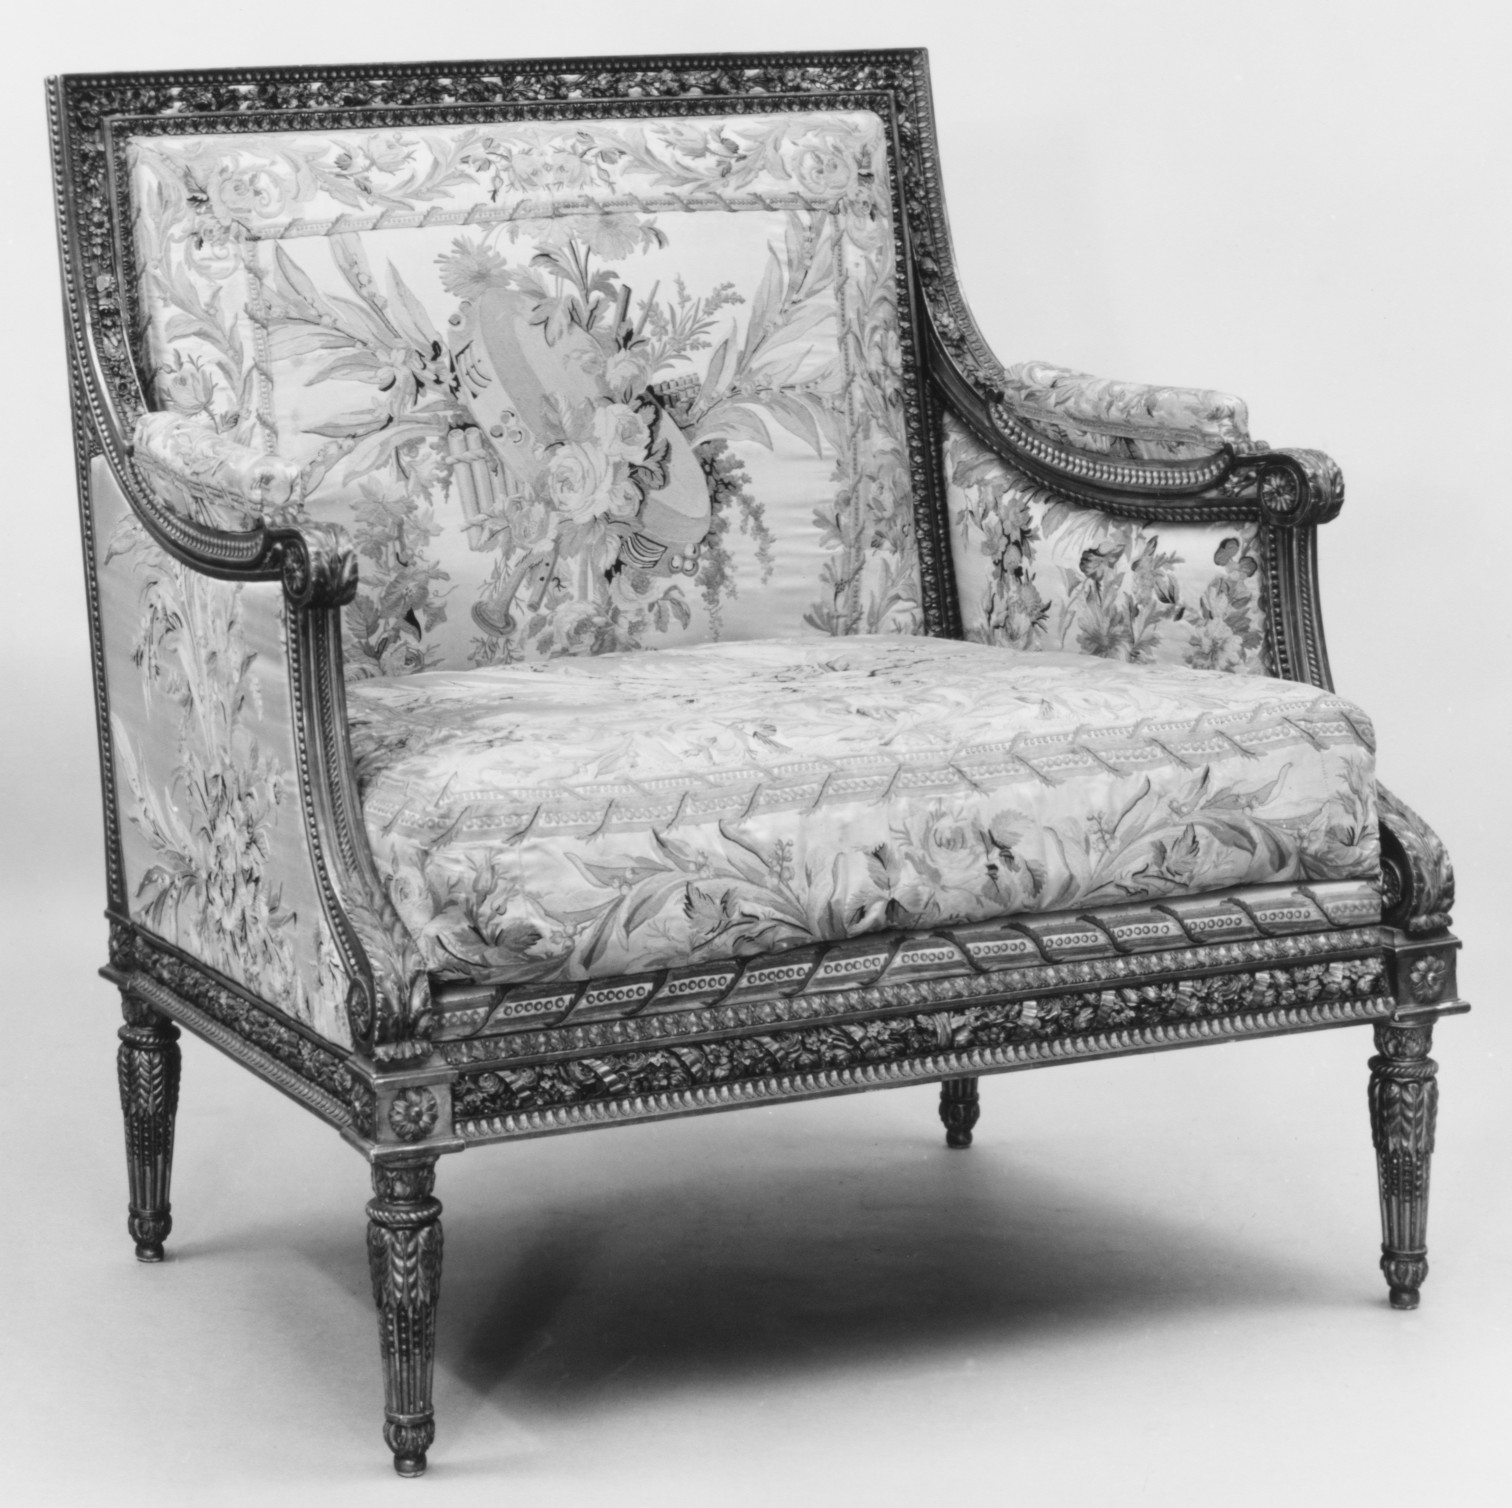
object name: settee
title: Small settee (Marquise) (part of a set)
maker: georges jacob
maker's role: maker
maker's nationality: french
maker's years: 1739-1814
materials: silk, wood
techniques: carving, embroidery, gilding